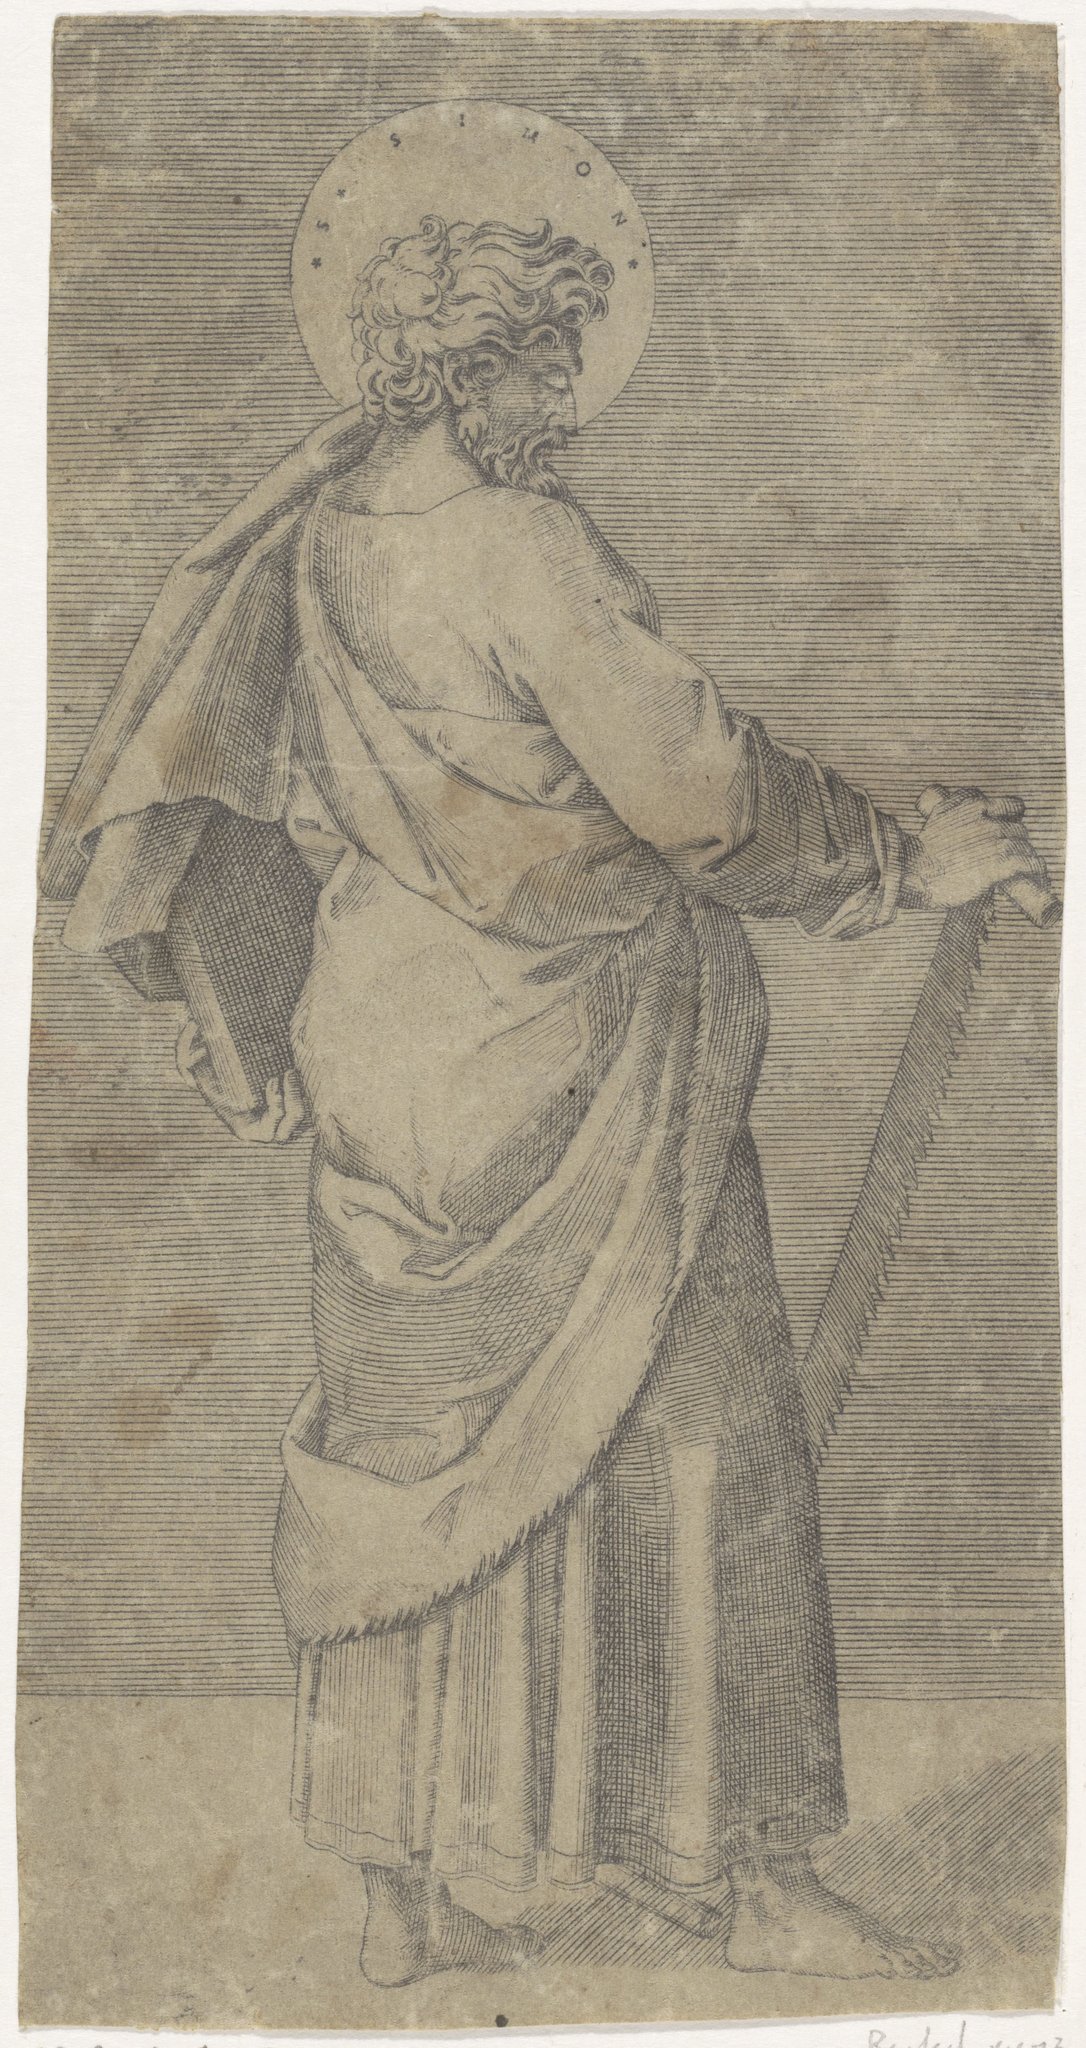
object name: print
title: S Simon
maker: marcantonio raimondi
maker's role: print maker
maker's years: 1470-1534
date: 1517-1527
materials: paper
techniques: engraving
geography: rome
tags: the apostle simon zelotes (or simon the canaanite); possible attributes: book, saw, scroll